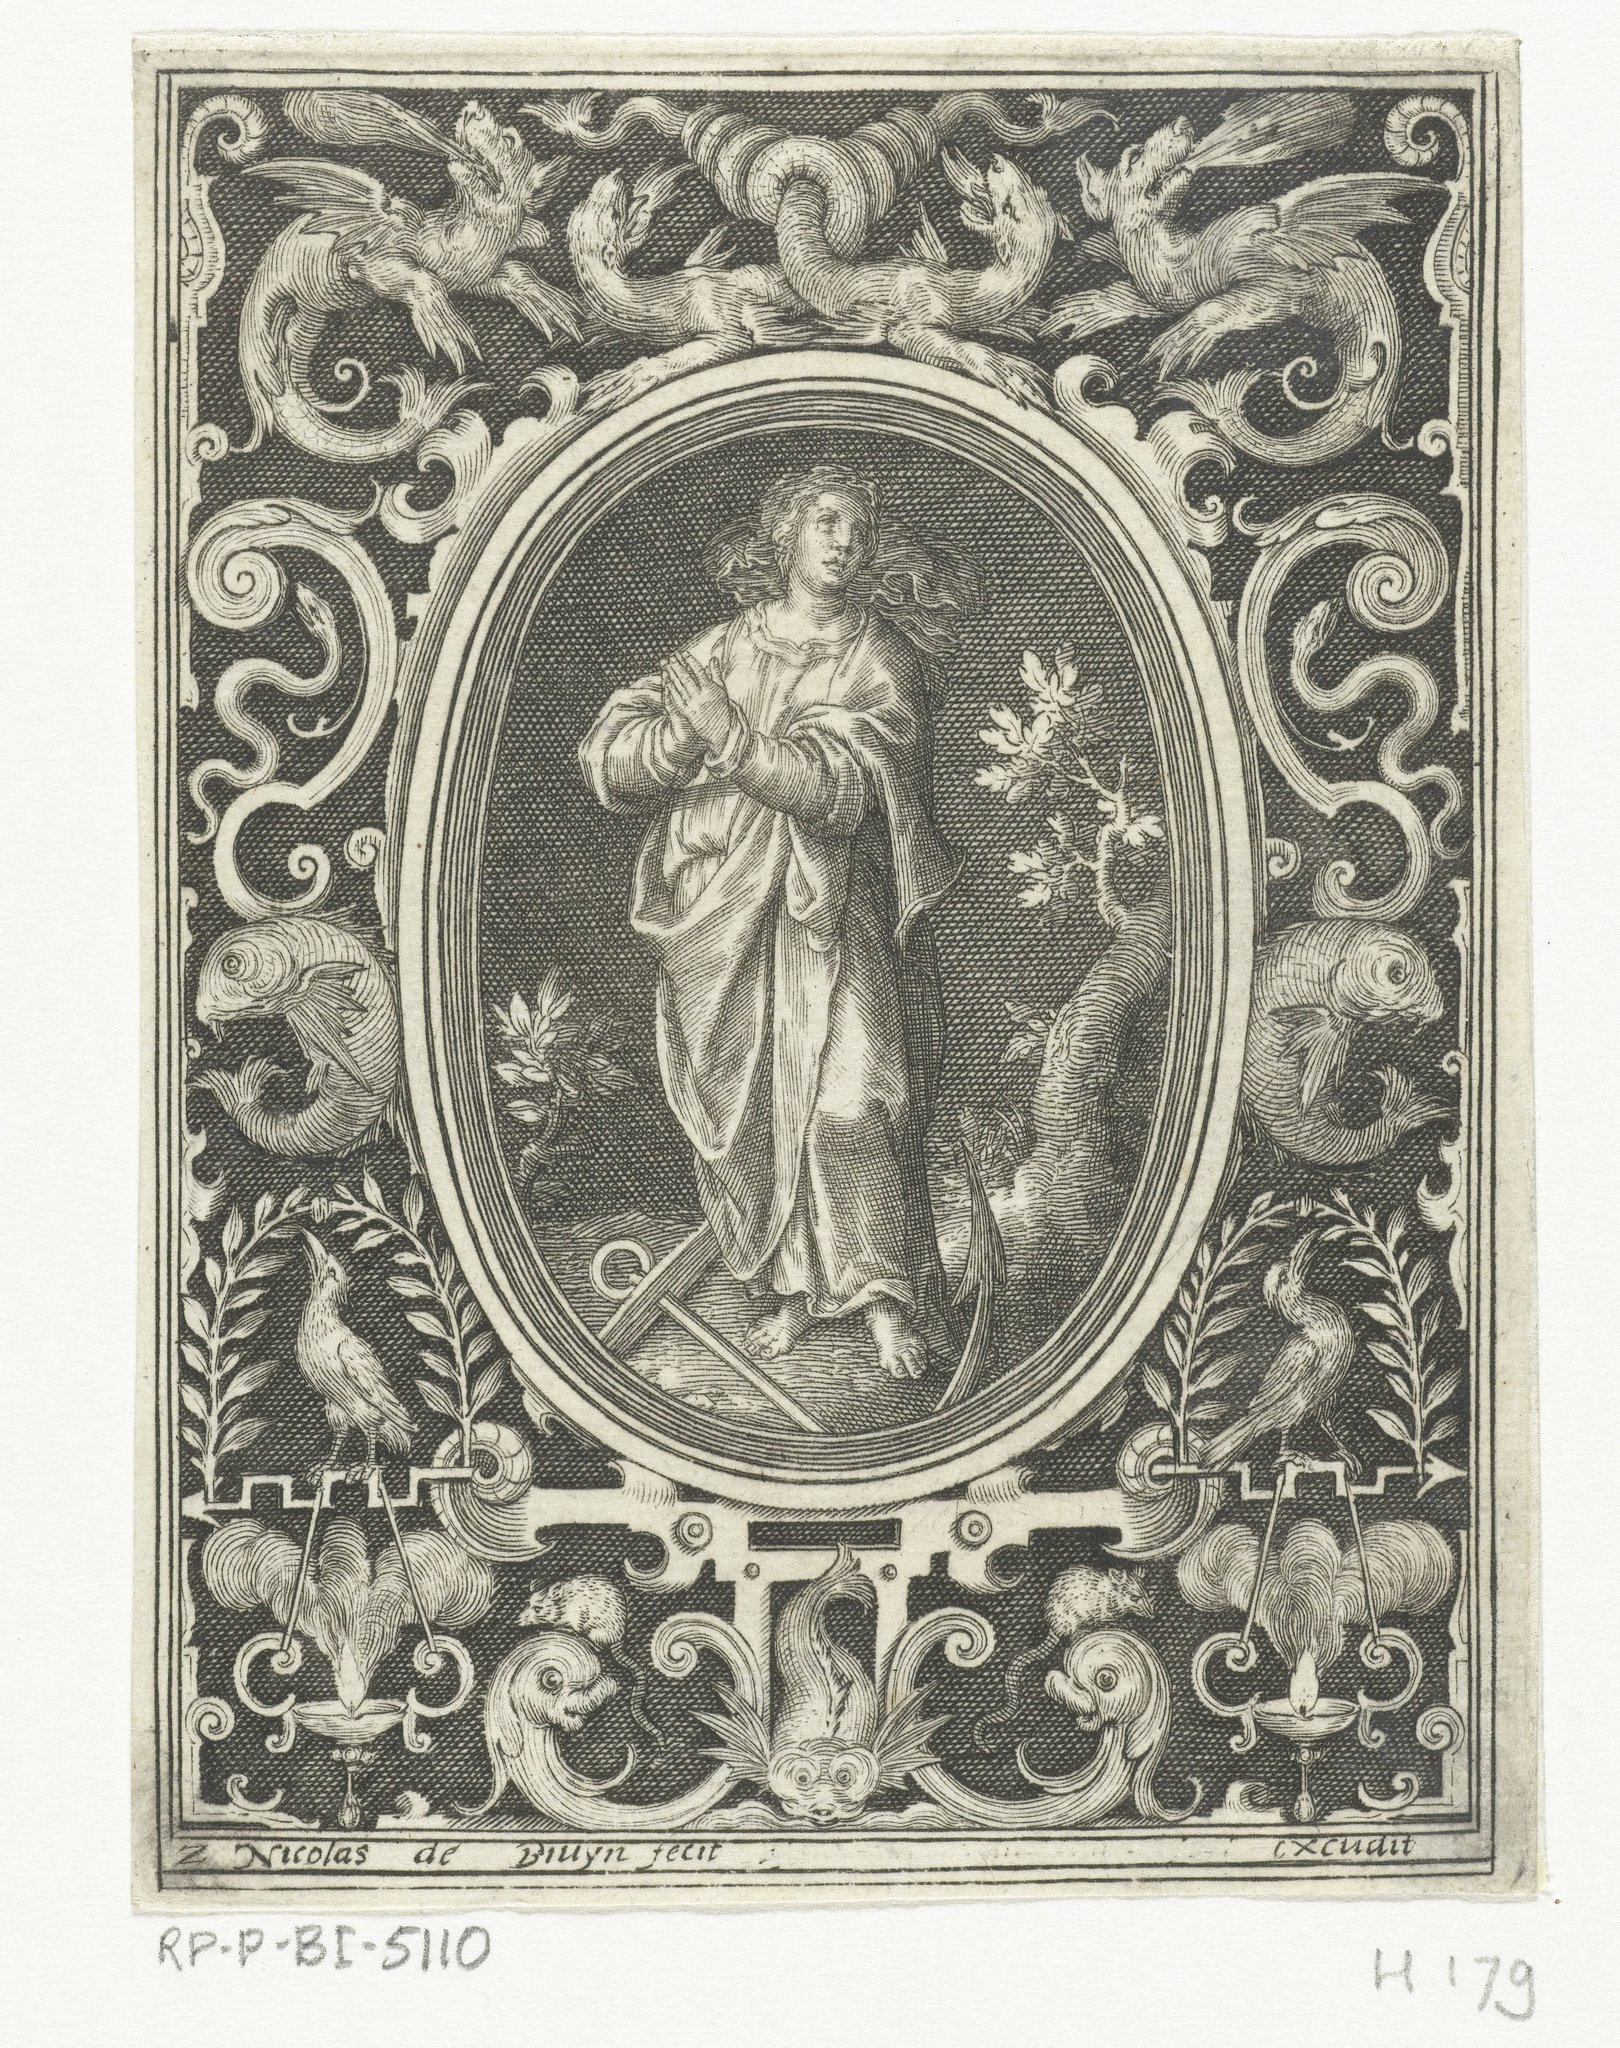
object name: print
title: Vier deugden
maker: nicolaes de bruyn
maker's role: print maker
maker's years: 1571-1656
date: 1581-1656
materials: paper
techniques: engraving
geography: netherlands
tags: hope, 'spes'; 'speranza divina e certa' (ripa) ~ one of the three theological virtues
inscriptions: collector's mark: Lugt 2228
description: Prent uit serie van vier prenten met deugden. De vier prenten in de collectie van het RMA vertegenwoordigen mogelijk vier verschillende uitgaven en staten van de reeks want het signatuur van de vervaardiger en het adres van de uitgever zijn steeds afwijkend genoteerd. Op het hier beschreven blad is waarschijnlijk het adres van uitgever Frederik de Wit verwijderd maar het woord excudit bleef staan.